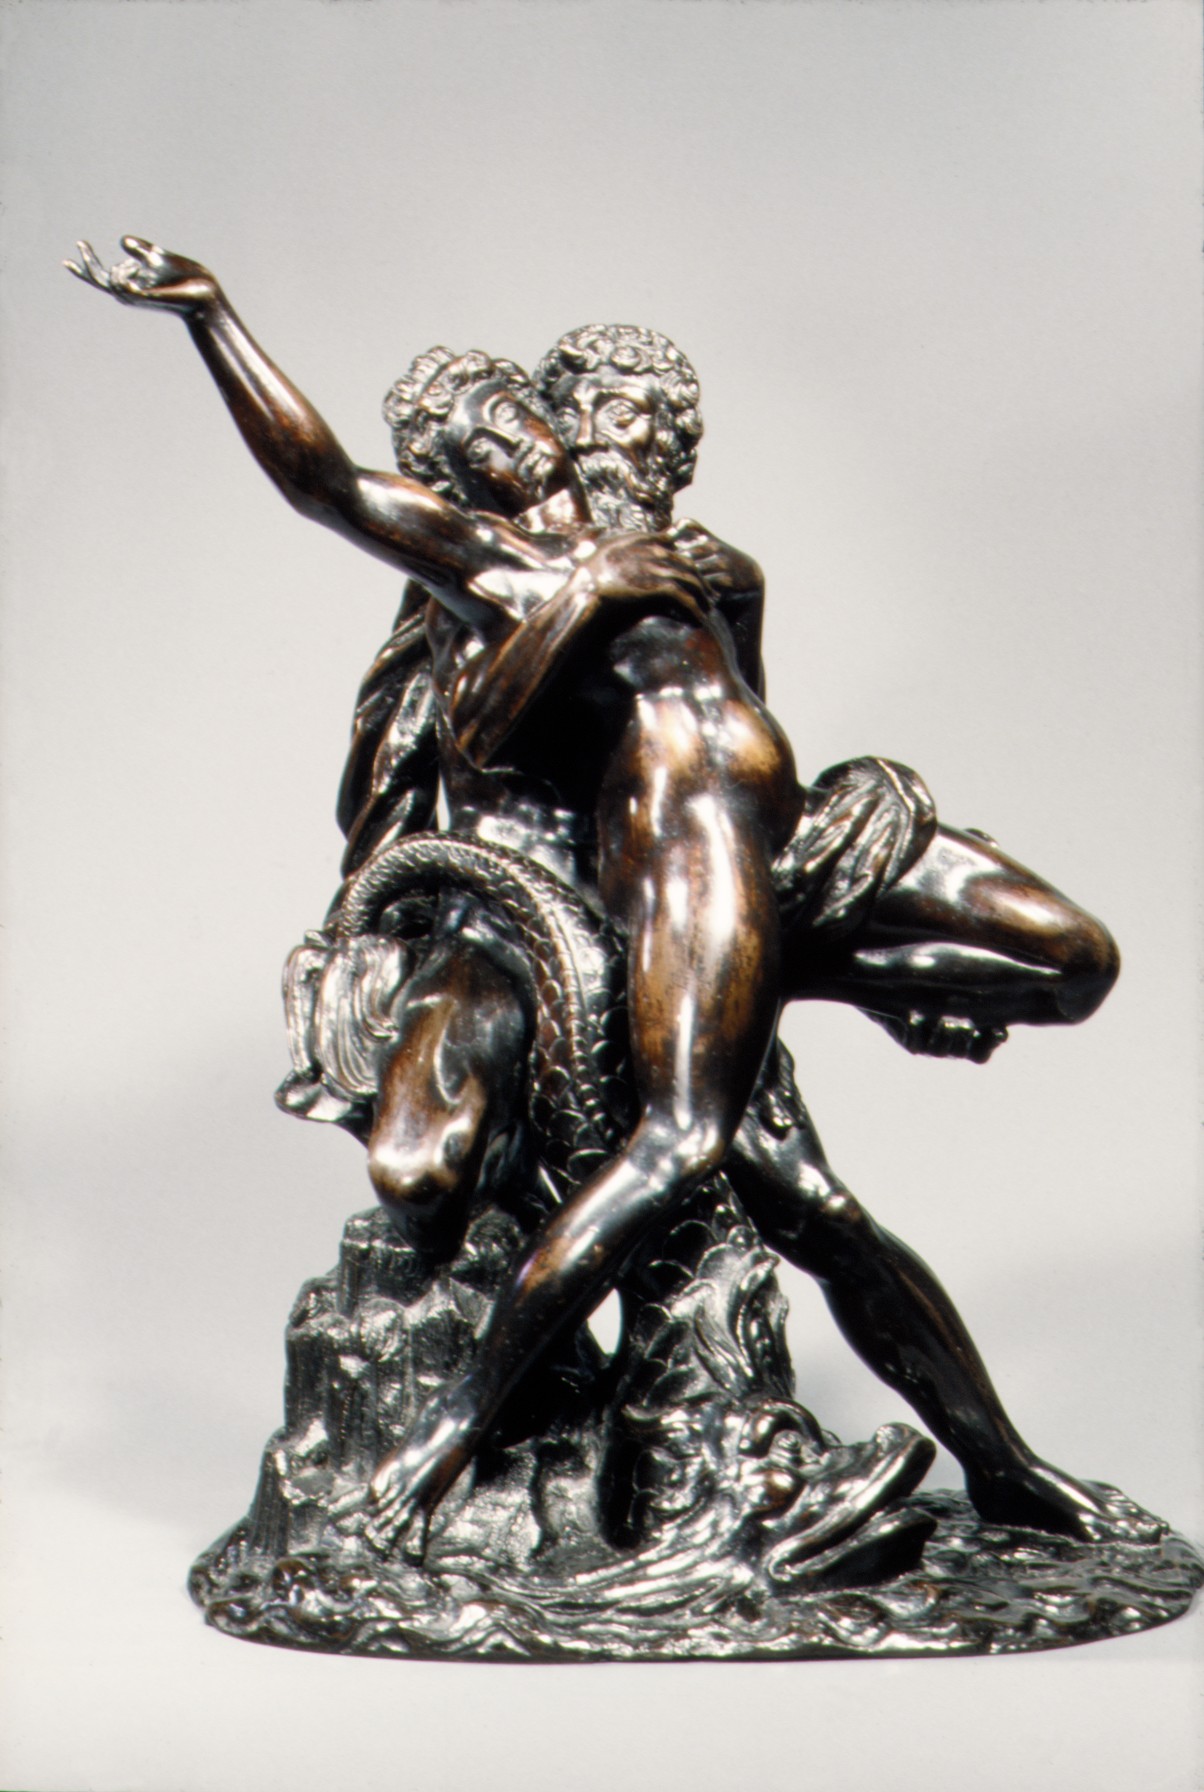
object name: statuette group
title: Neptune and Caenis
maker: johann sadeler (i)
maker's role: artist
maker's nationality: netherlandish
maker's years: 1550-1601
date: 1567-1633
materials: bronze, lacquer, patina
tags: women,neptune